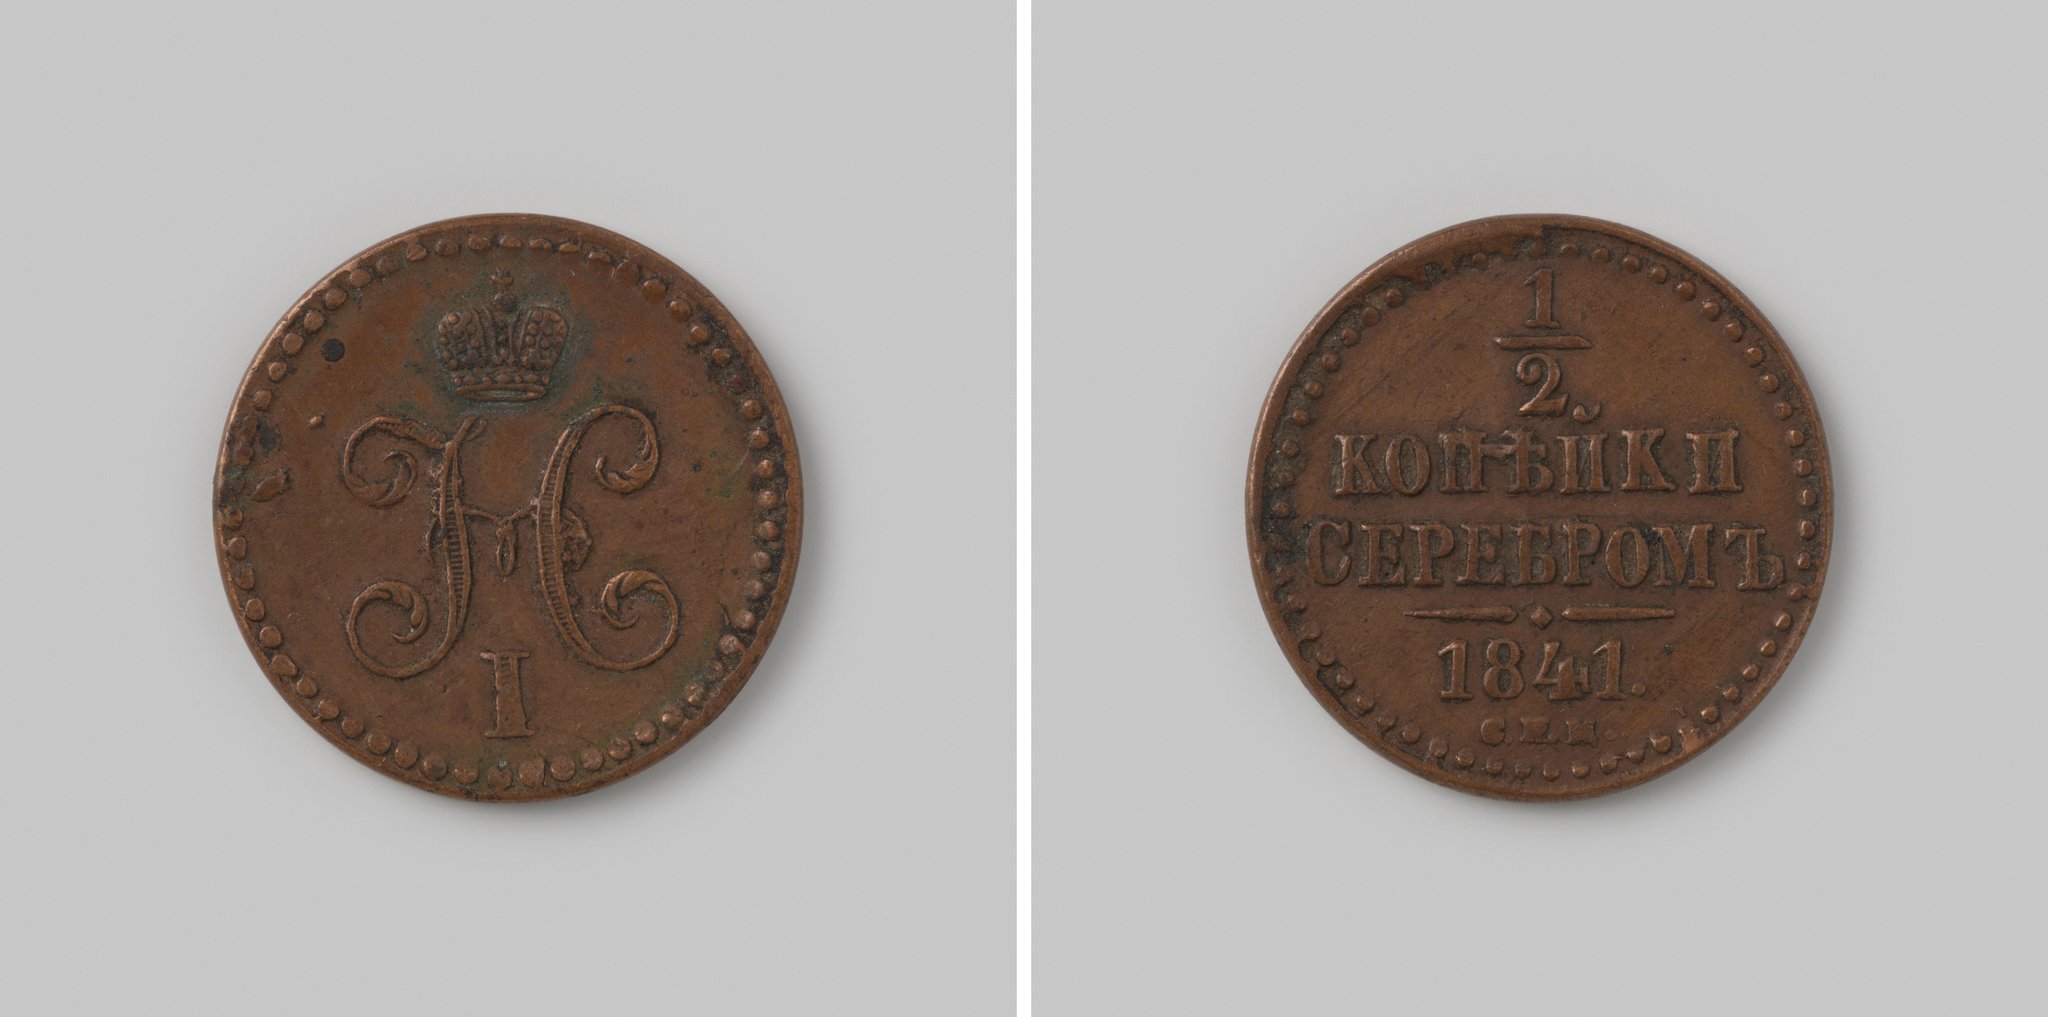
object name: coin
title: ½ kopek uit Rusland van tsaar Nikolai I, 1841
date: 1841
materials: copper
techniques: striking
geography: sint-petersburg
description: Koperen munt. Voorzijde: gekroond monogram van Nicolai I in het cyrillisch. Keerzijde: in drie regels waarde-aanduiding. Daaronder jaartal, waaronder in het Cyrillisch de letters S,P en B [=Sint Petersburg]. Gladde rand.